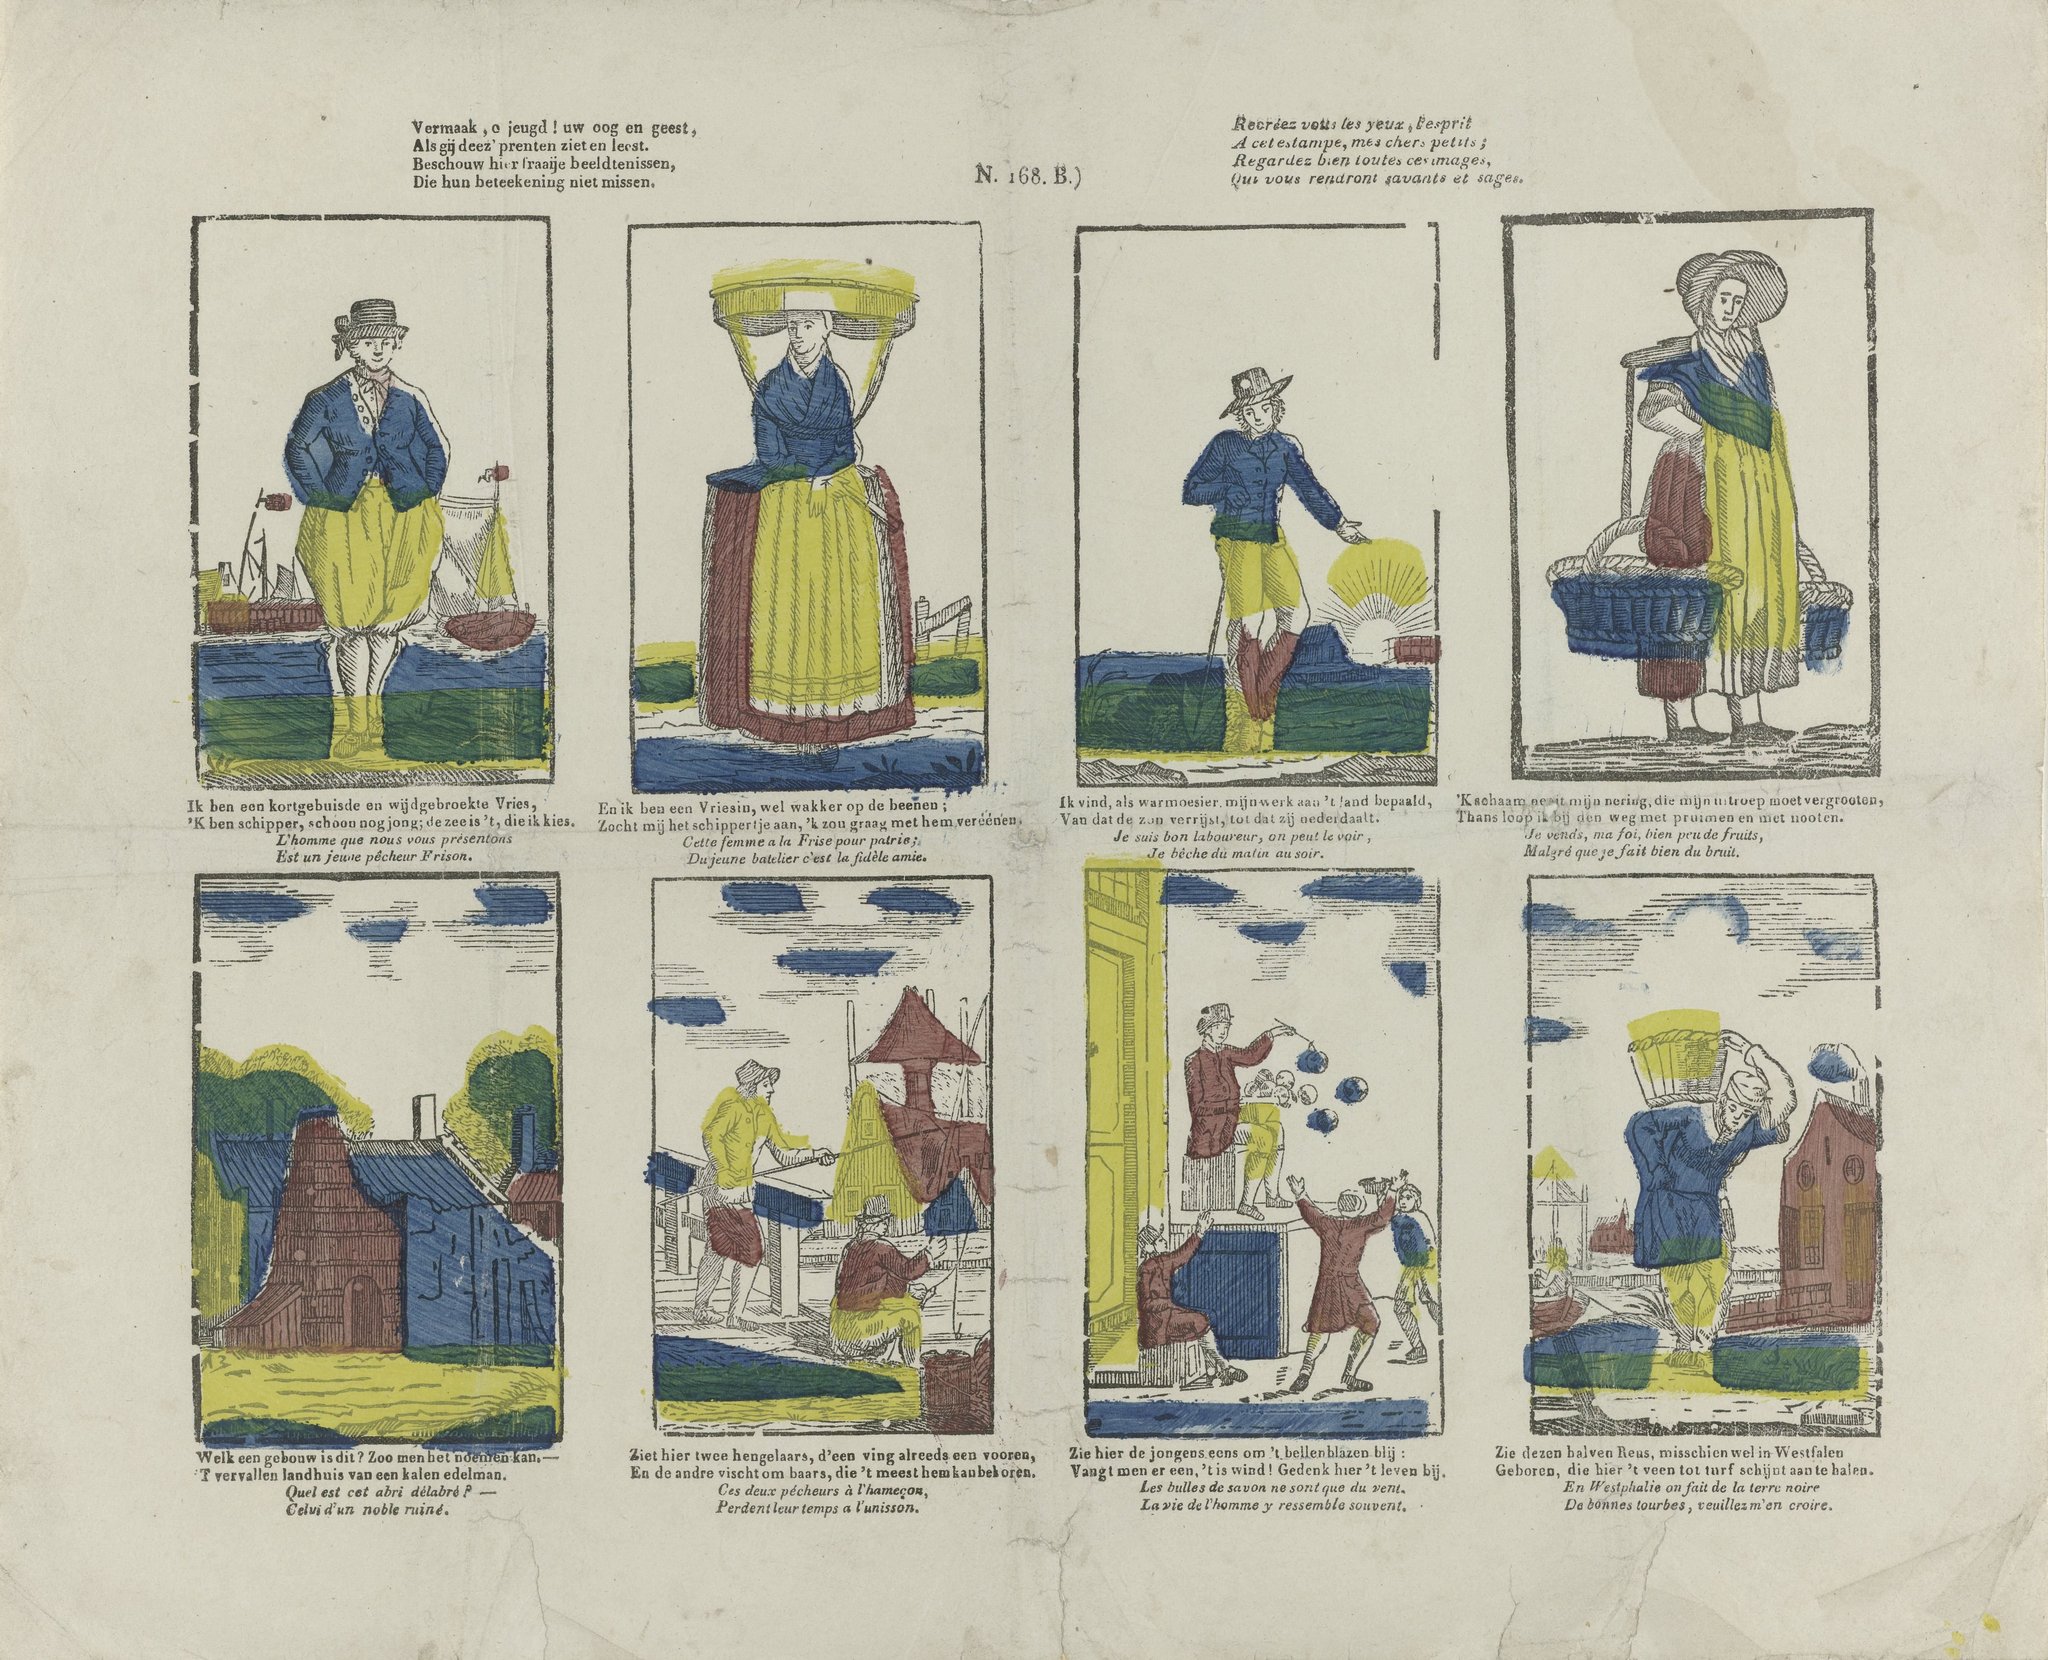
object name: print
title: Vermaak, o jeugd! uw oog en geest, / Als gij deez' prenten ziet en leest [(...)]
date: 1800-1833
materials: paper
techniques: colour, letterpress printing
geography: turnhout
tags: farmers, street-trader, crafts and industries, fisherman, merchant, salesman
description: Blad met 8 voorstellingen van beroepen, waaronder een schipper, een boer en vissers. Onder elke afbeelding een tweeregelig vers in het Nederlands en in het Frans. Genummerd midden boven: N. 168. B.).